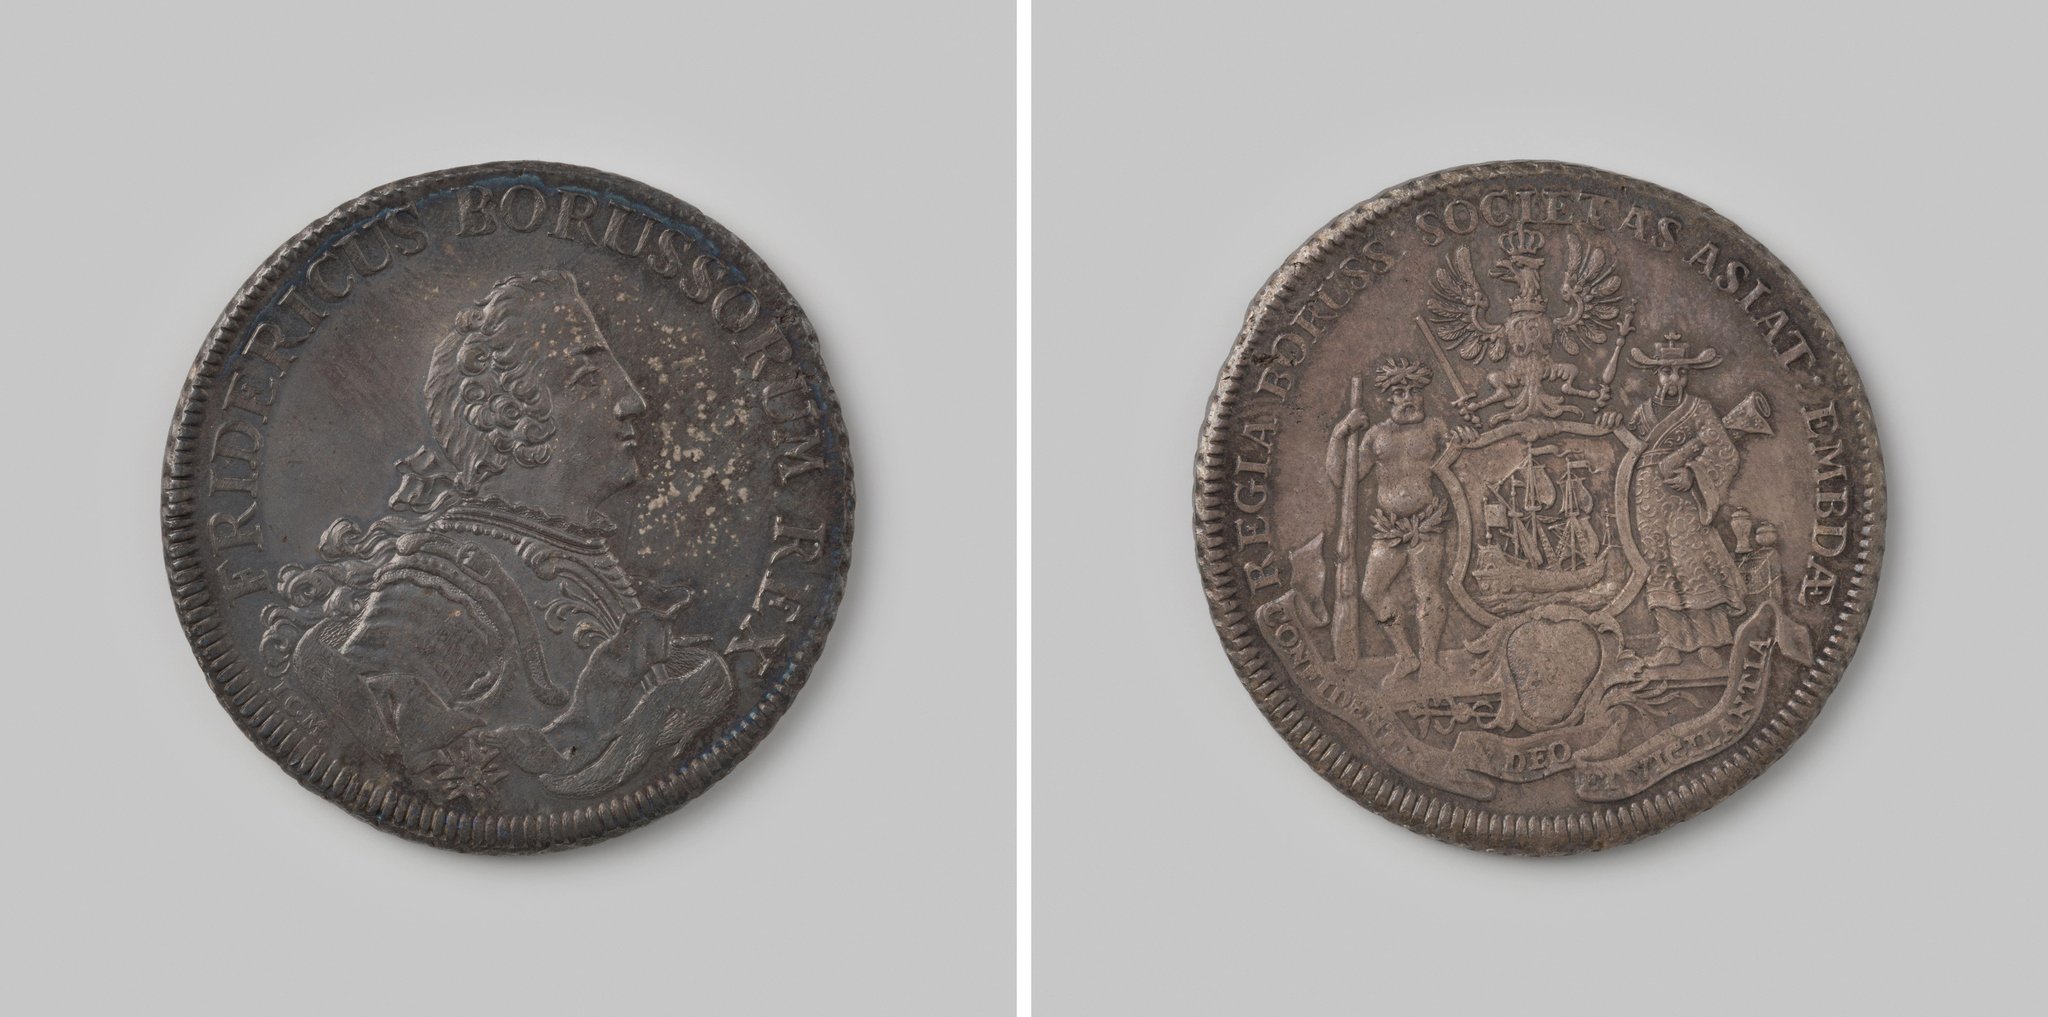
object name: coin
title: Koninklijke Pruisisch-Aziatische Compagnie van Emden, piaster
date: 1751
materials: silver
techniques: striking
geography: cleves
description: Zilveren munt. Voorzijde: borstbeeld van koning Friedrich II van Pruisen naar rechts. Keerzijde: door schildhouders gehouden wapensschild, waarboven gekroonde adelaar en waaronder kleiner schild met in drie regels letters K, A, P , C en E, waaromheen wapenspreuk. Kabelrand.